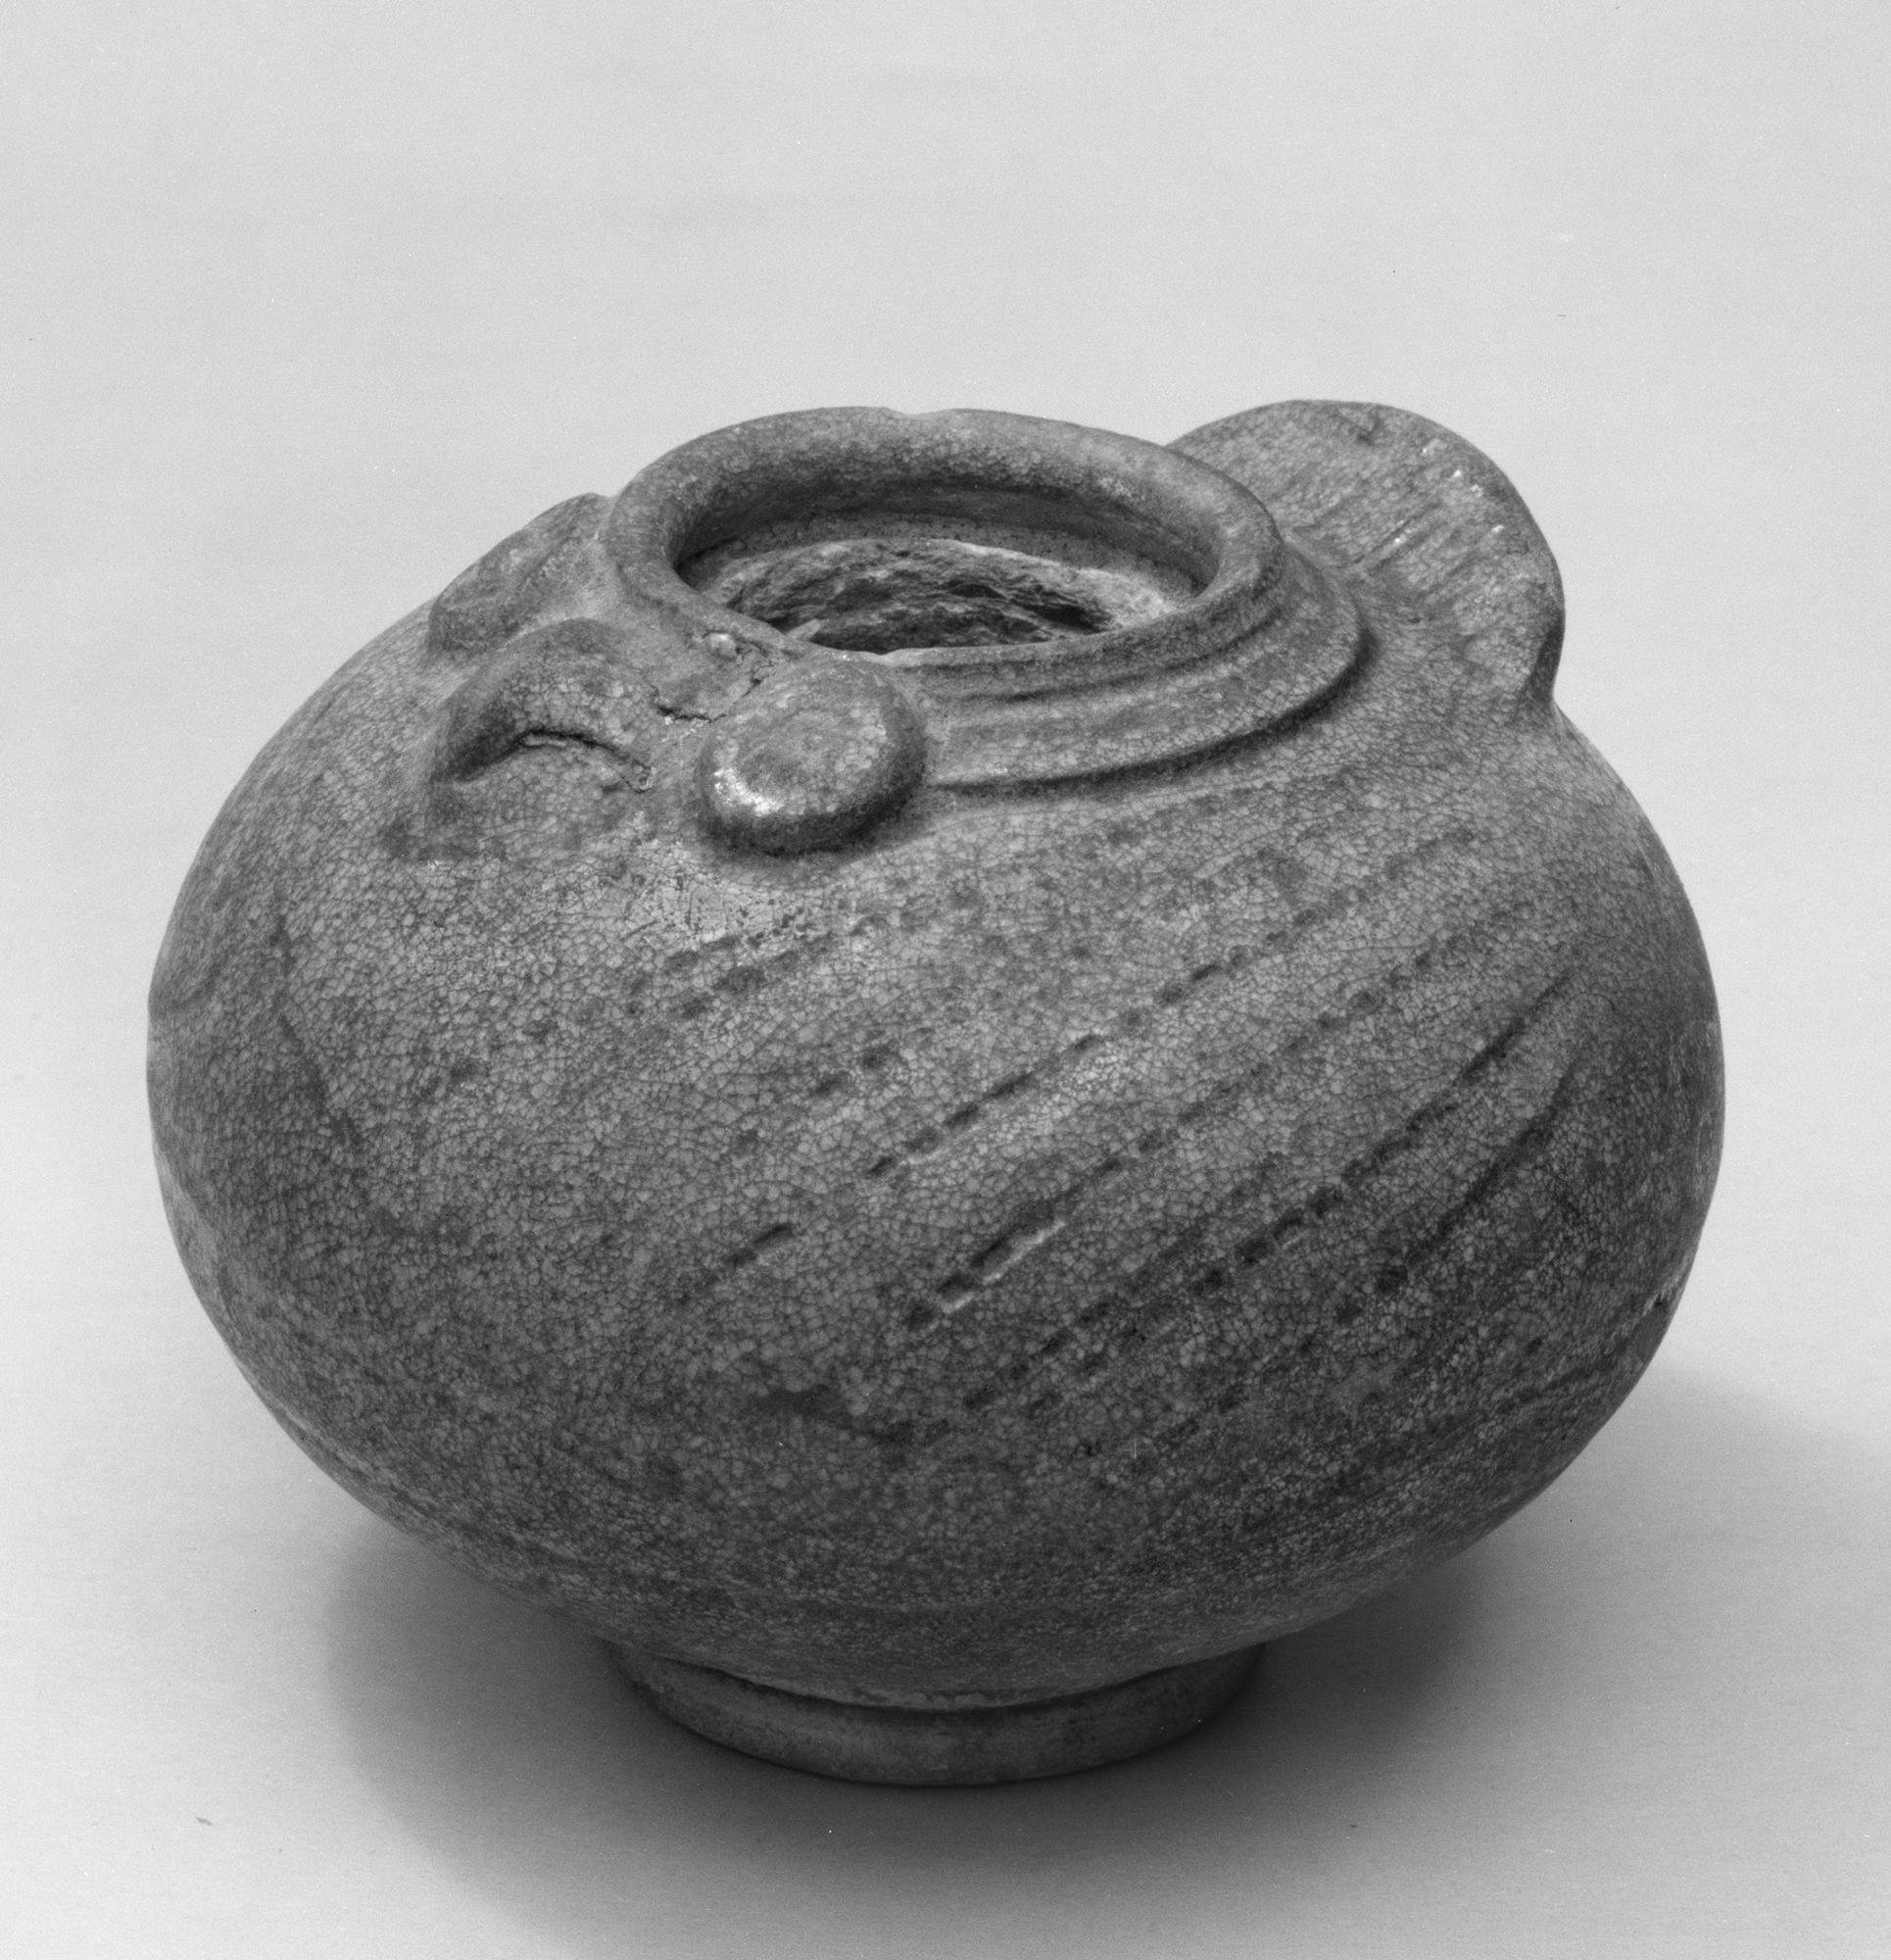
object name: water pot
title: Water pot in the shape of a bird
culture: chinese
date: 201-400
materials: ceramic glaze, glaze, stoneware